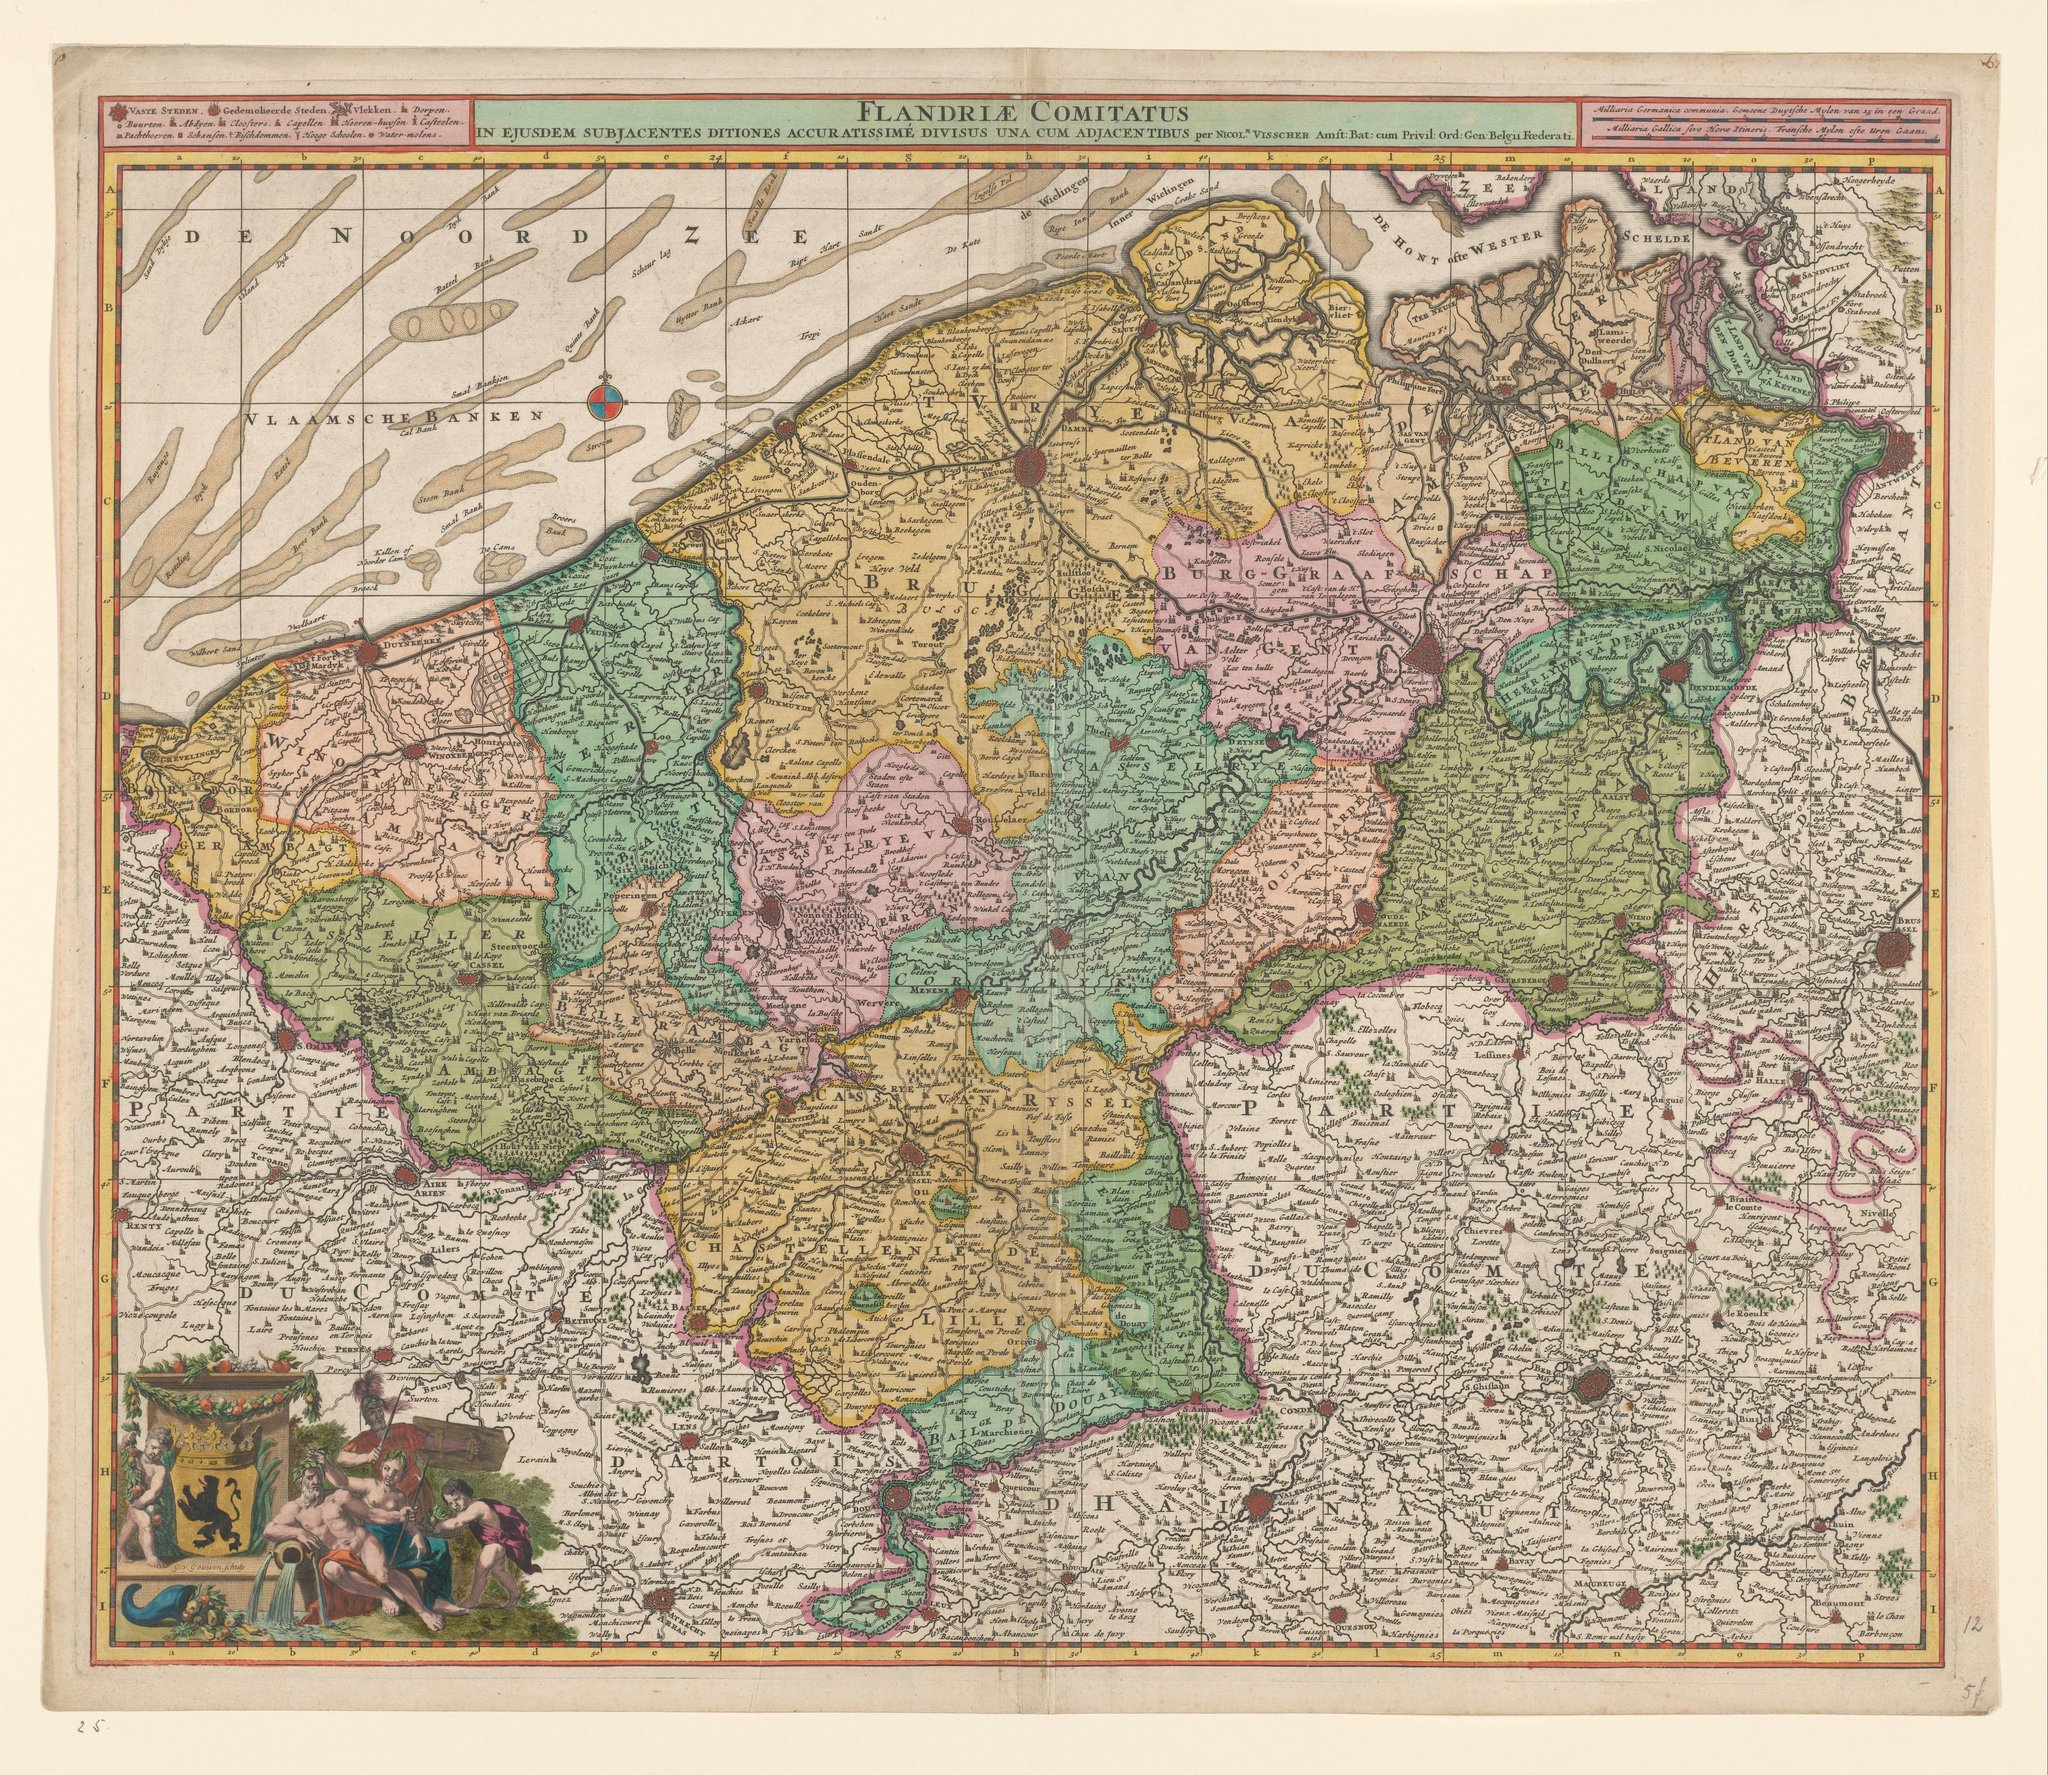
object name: map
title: Kaart van het graafschap Vlaanderen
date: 1680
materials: paper, watercolor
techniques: engraving, hand coloring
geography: amsterdam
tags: maps of separate countries or regions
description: Kaart van het graafschap Vlaanderen. Linksboven, naast de titel, de legenda. Rechtsboven de schaal in Duitse en Franse mijlen. Windroos linksboven in zee, linksonder het wapenschild van Vlaanderen, omgeven door allegorsiche figuren en putti. Op de kaart zijn bomen en vestigingen aangegeven.